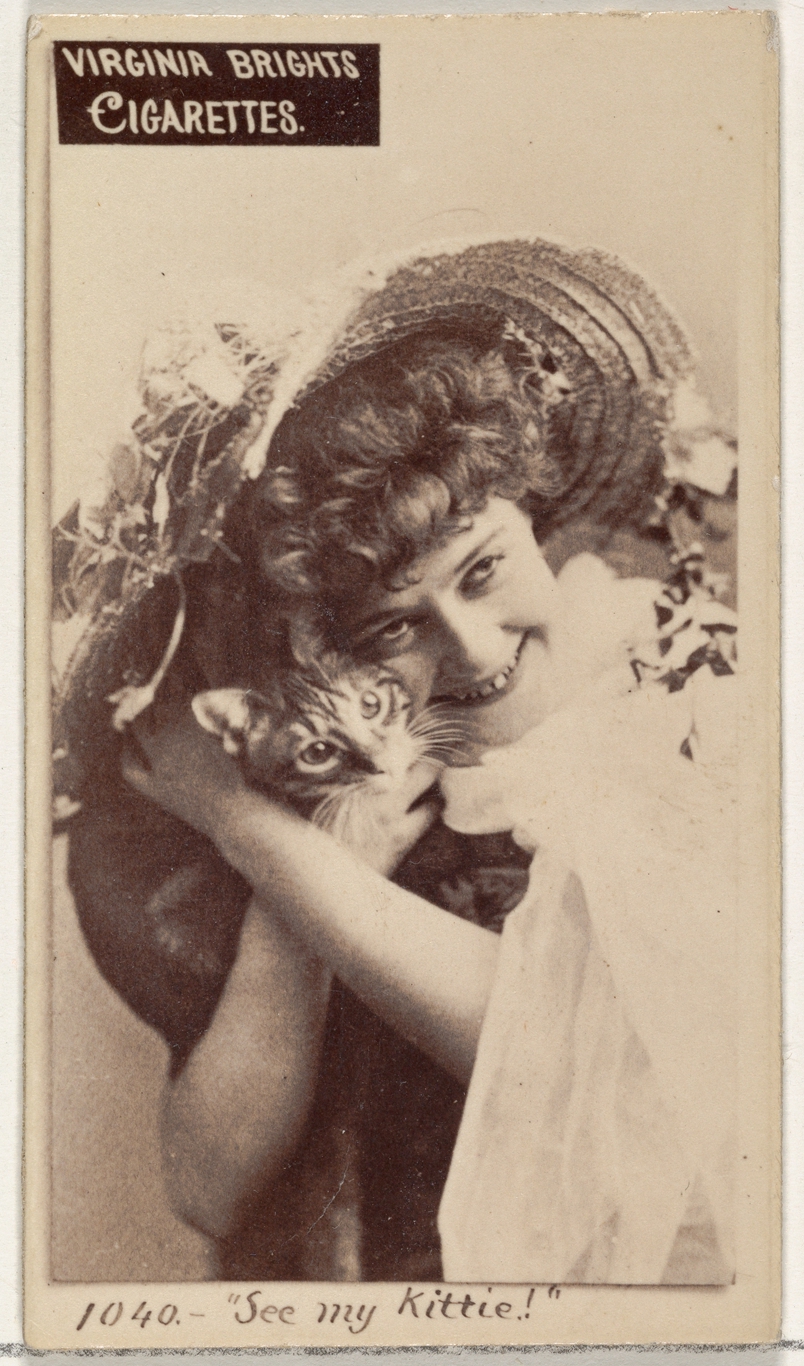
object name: photograph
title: Card 1040, "See my Kittie!", from the Actors and Actresses series (N45, Type 2) for Virginia Brights Cigarettes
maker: allen & ginter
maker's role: publisher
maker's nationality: american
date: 1888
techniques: albumen silver print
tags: portraits,women,cats